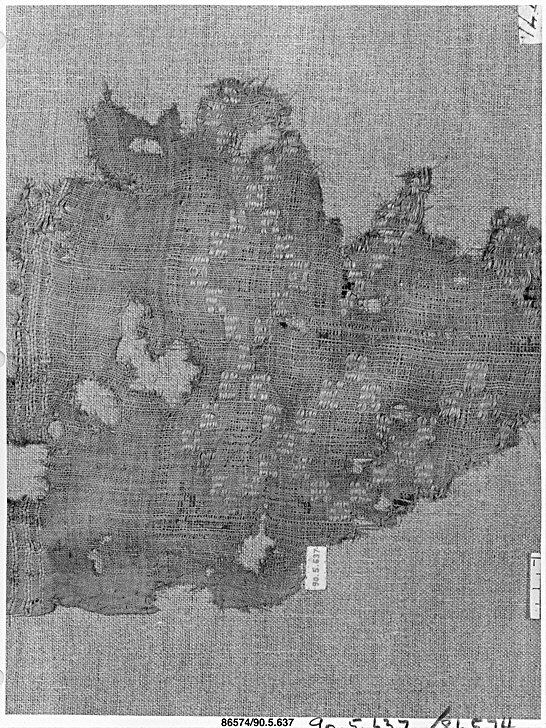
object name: textile fragment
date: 301-500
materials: linen, wool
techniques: weave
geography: egypt